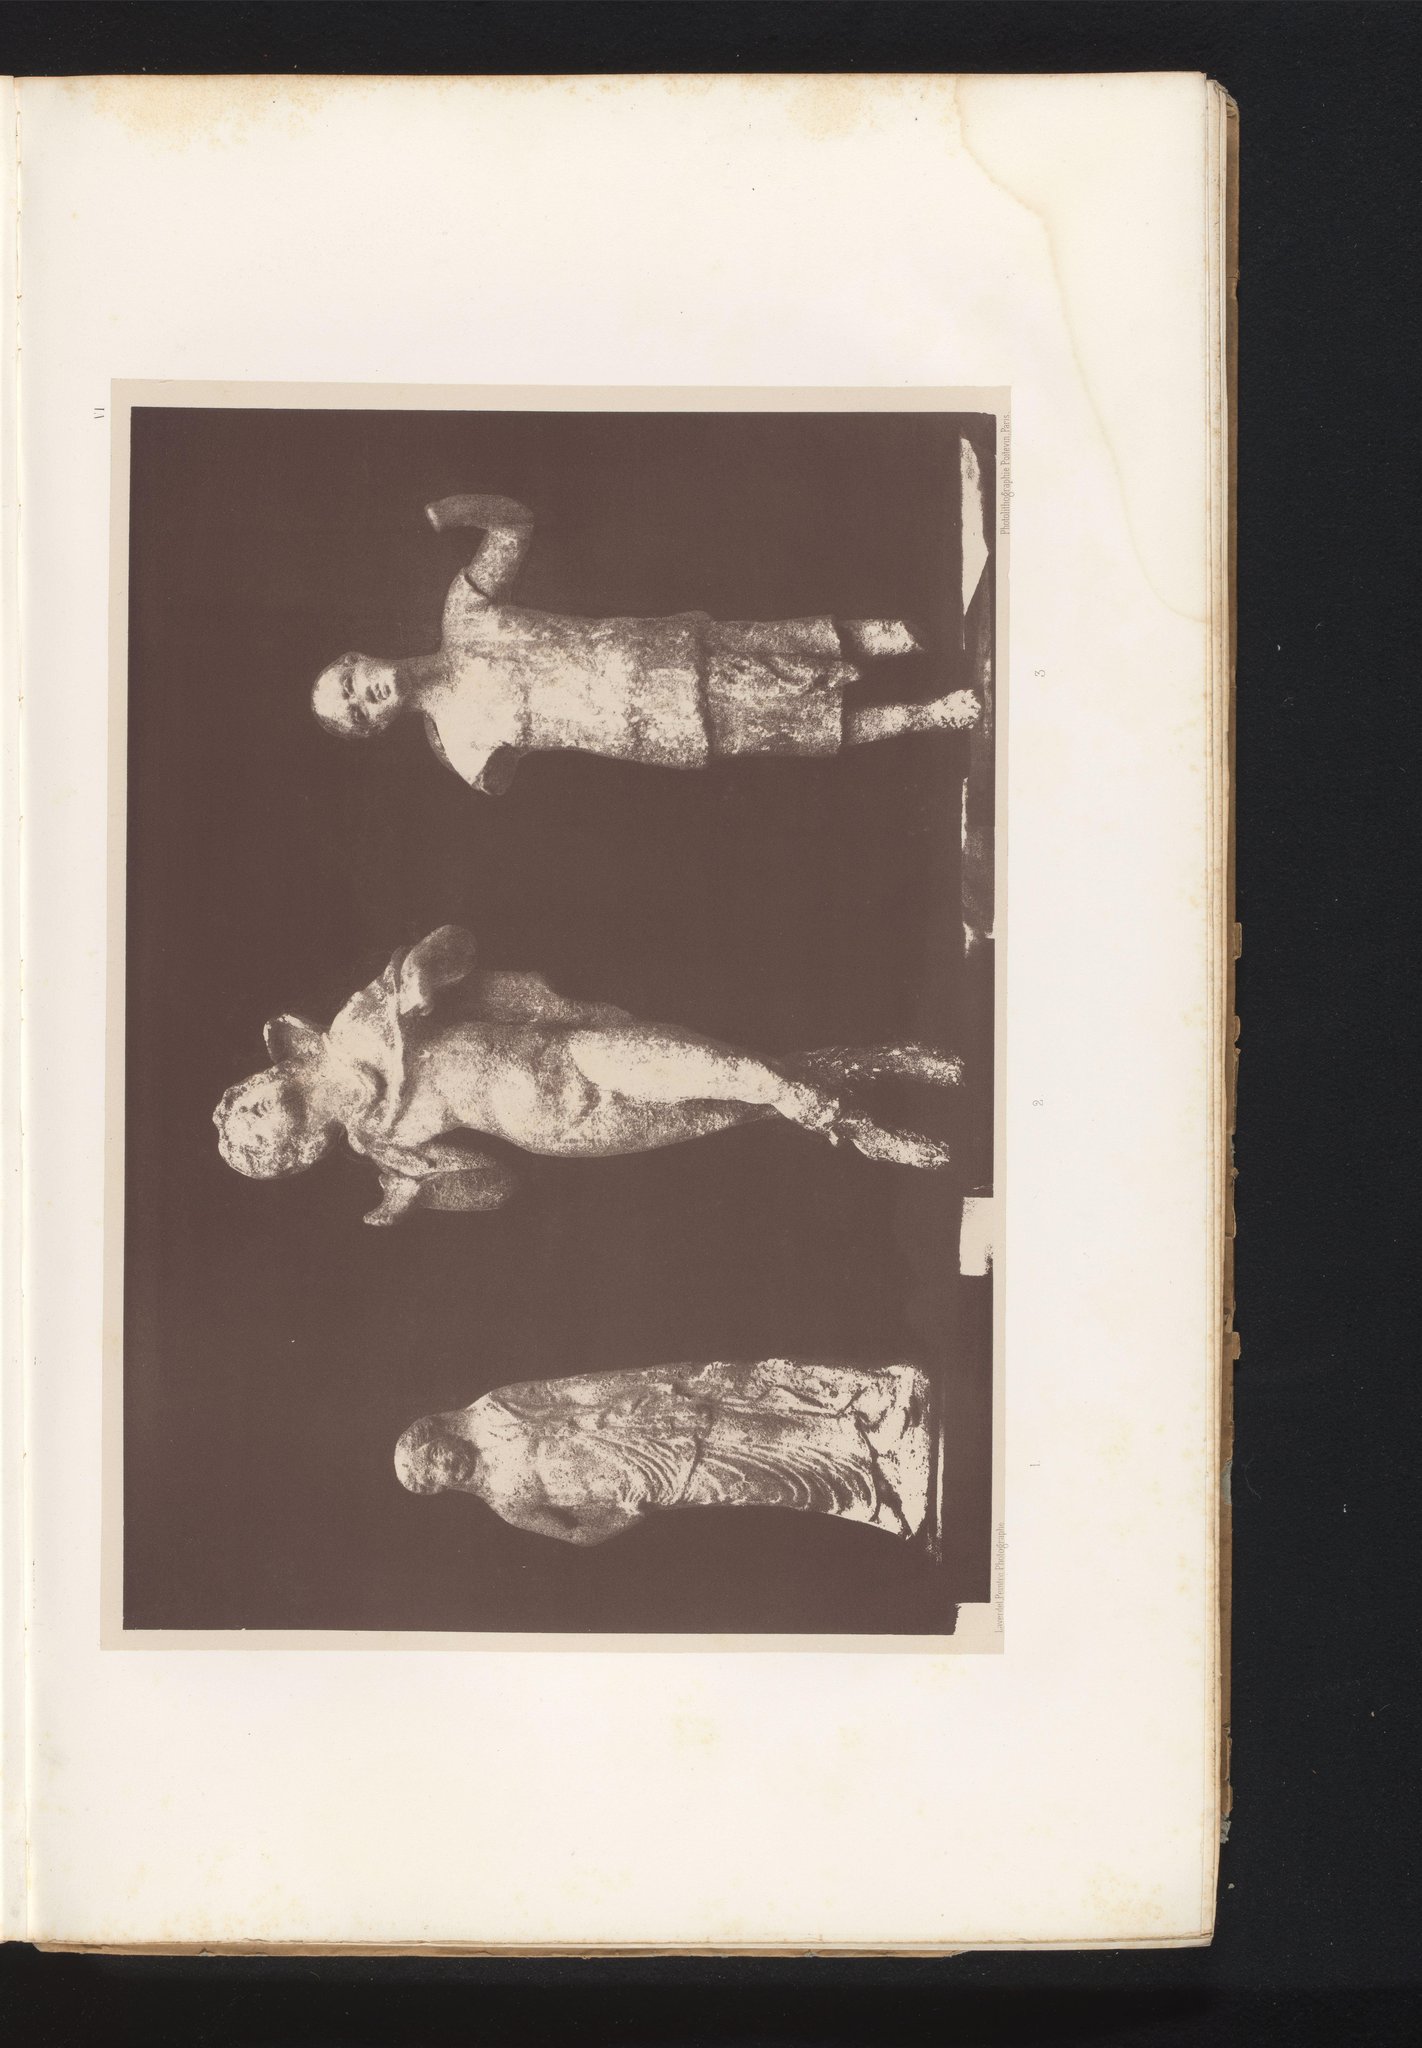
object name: page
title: Drie terracotta sculpturen van een jonge vrouw in dubbele tuniek, een jonge satyr en een man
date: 1852-1857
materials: paper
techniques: photolithography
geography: paris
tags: adult woman, piece of sculpture, reproduction of a piece of sculpture (+ clay, sand, etc. ~ arts), adult man, satyr(s) (in general)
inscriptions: number: ‘VI.’, number: ‘1. 2. 3.’